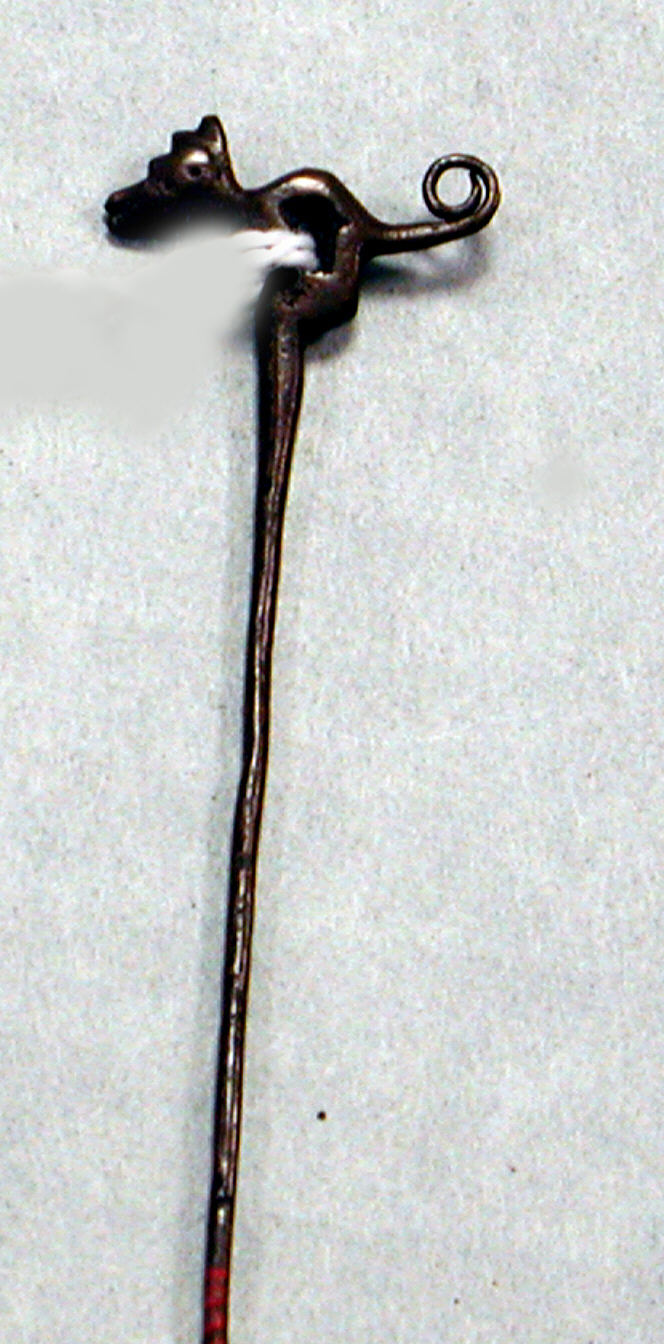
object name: lime spoon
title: Copper Lime Spoon with Monkey Top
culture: chimú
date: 1101-1500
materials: copper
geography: peru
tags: monkeys